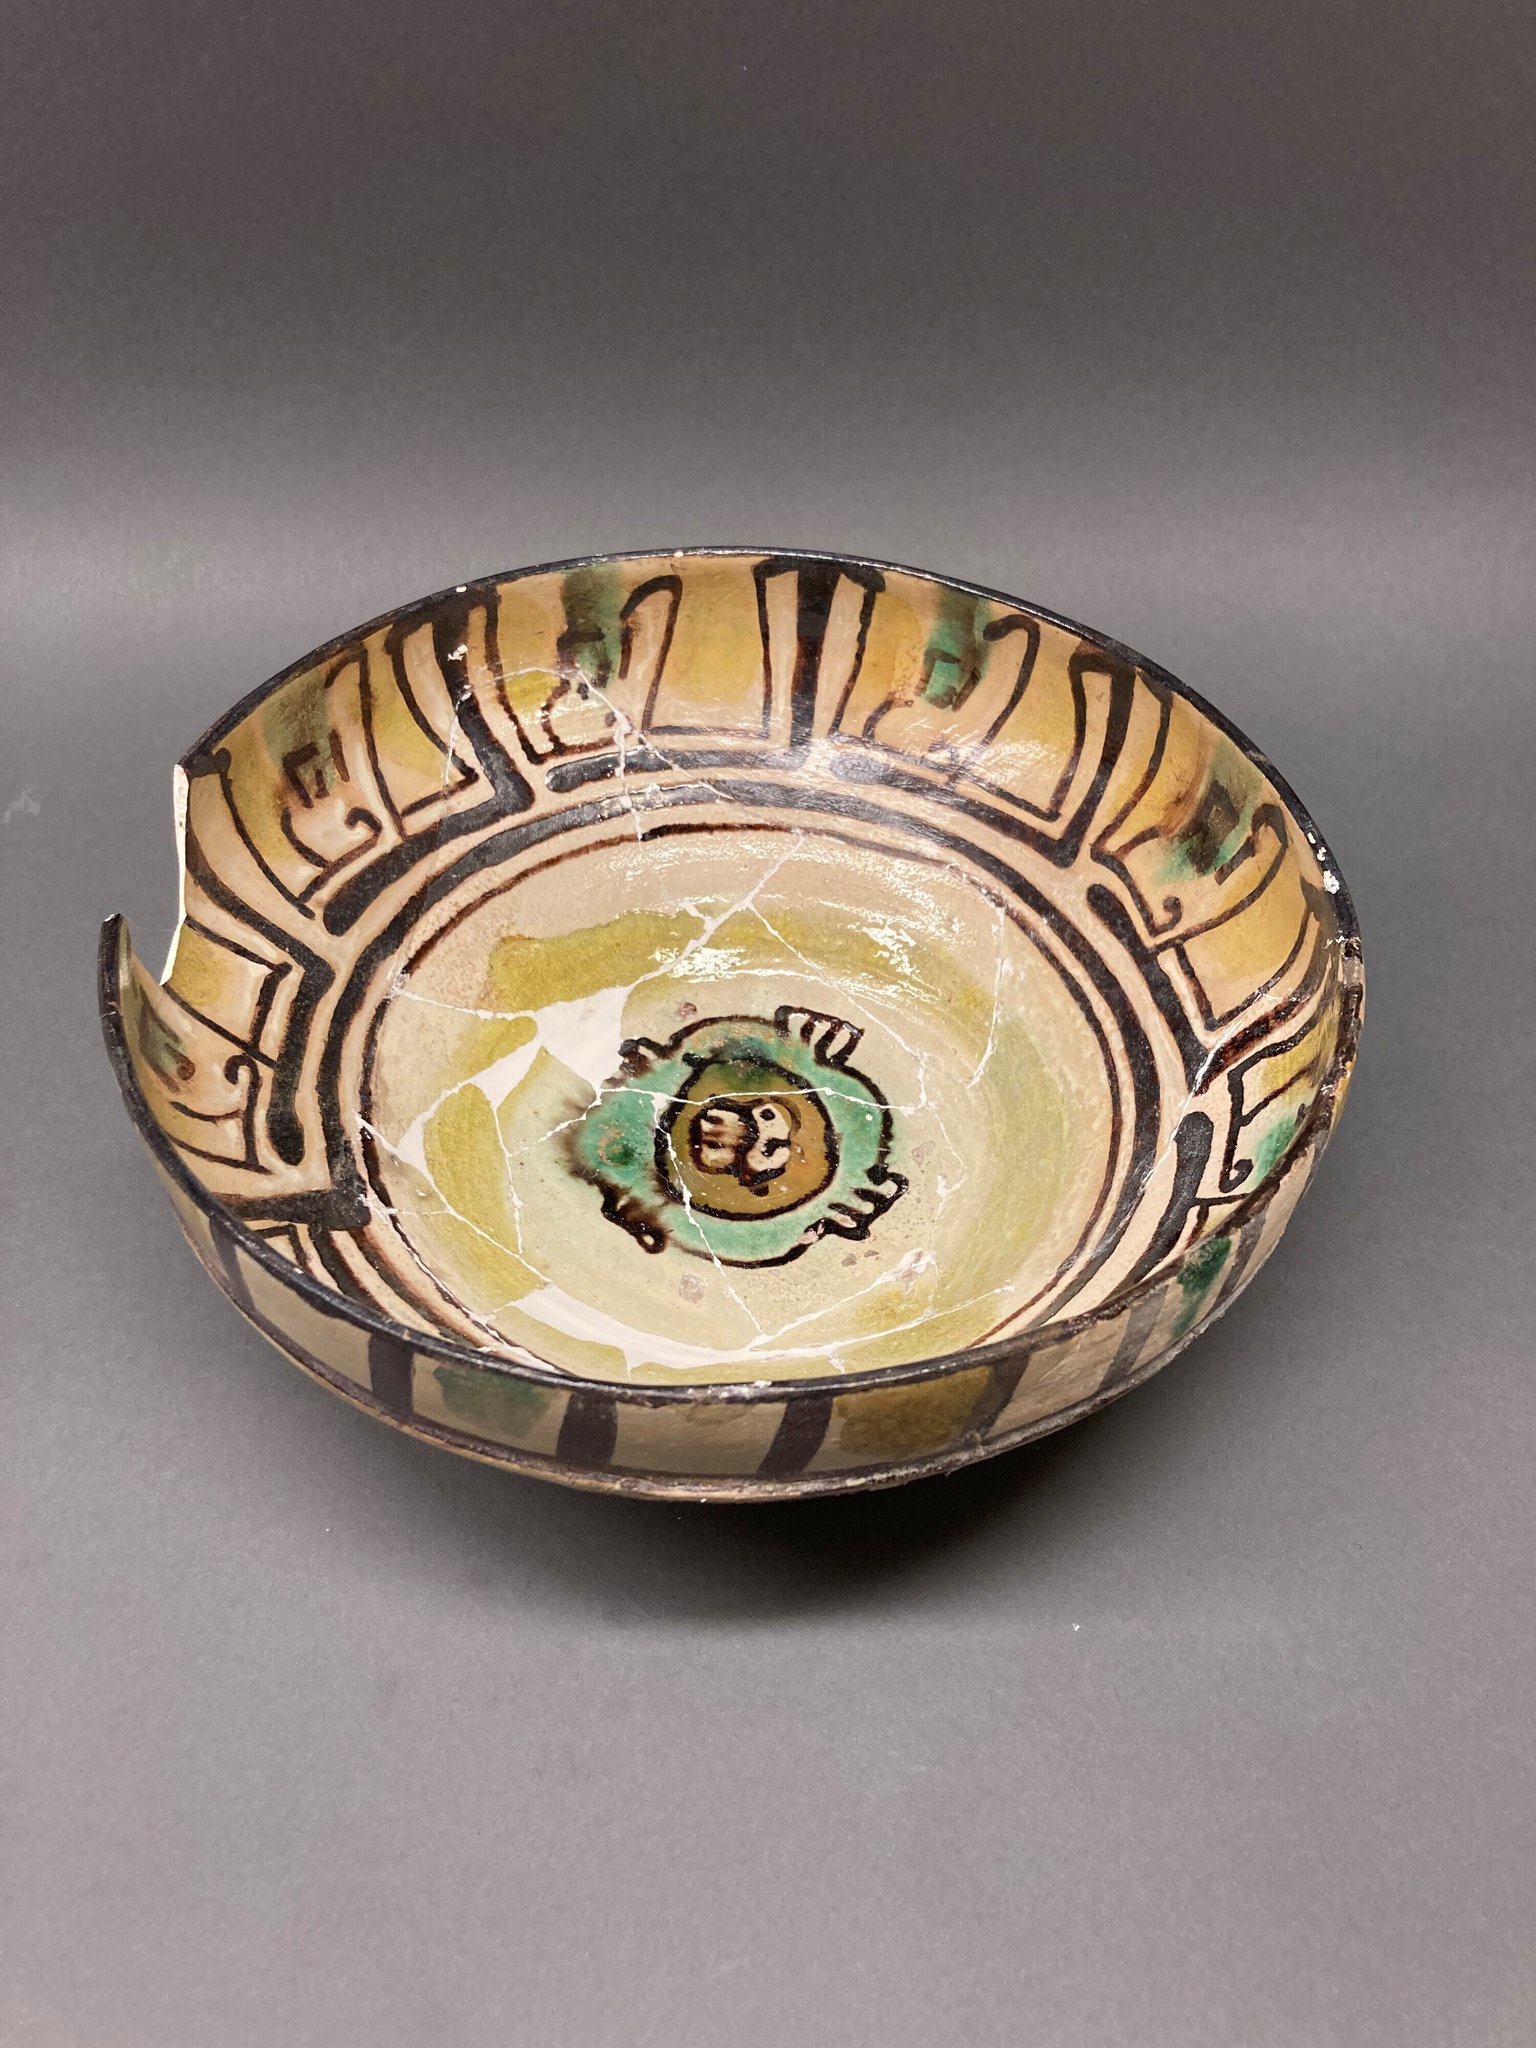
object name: dish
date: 801-1000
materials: earthenware, glaze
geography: iran